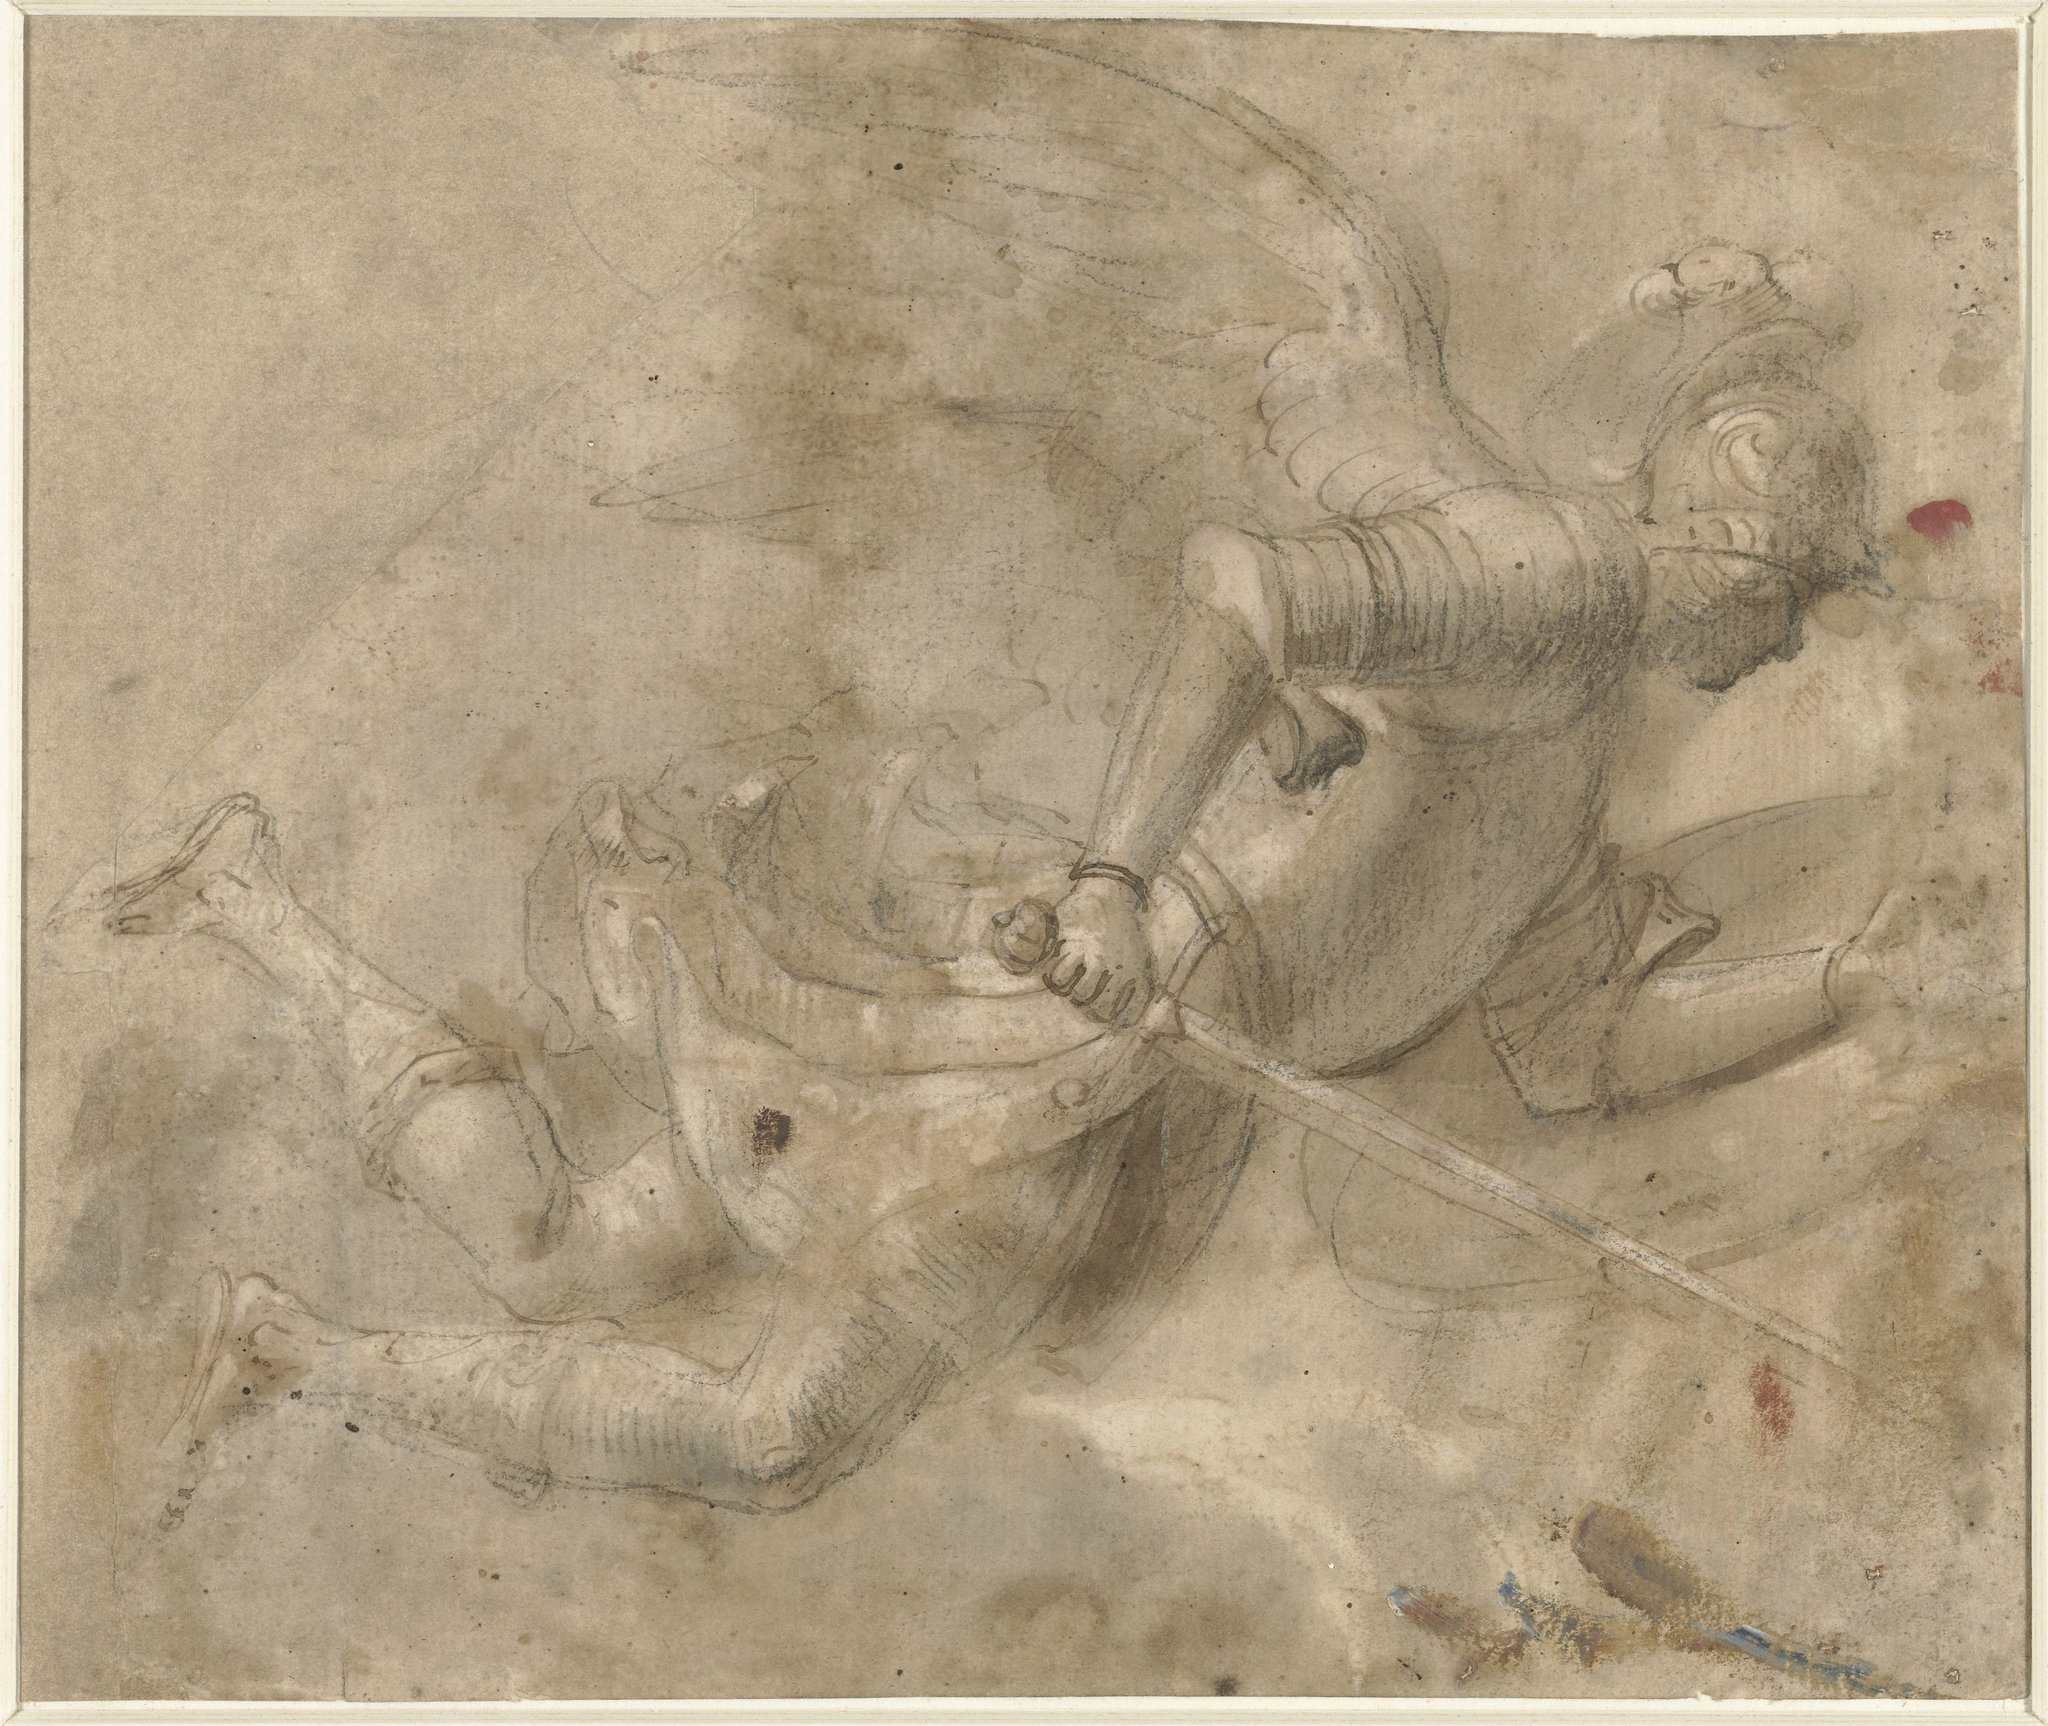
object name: drawing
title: Aanvliegende geharnaste H. Michaël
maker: Anonymous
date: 1500-1599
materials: chalk, ink, paper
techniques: brush, pen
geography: northern italy